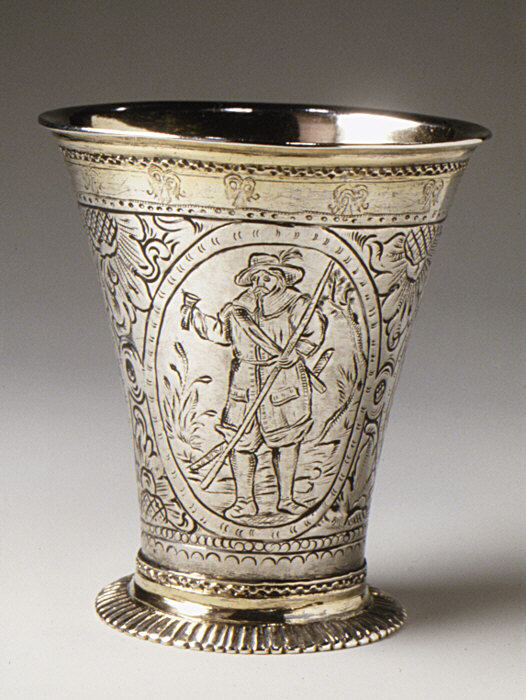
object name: beaker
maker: johan leffler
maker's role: maker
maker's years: 1723-1796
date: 1766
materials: gilt, silver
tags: men